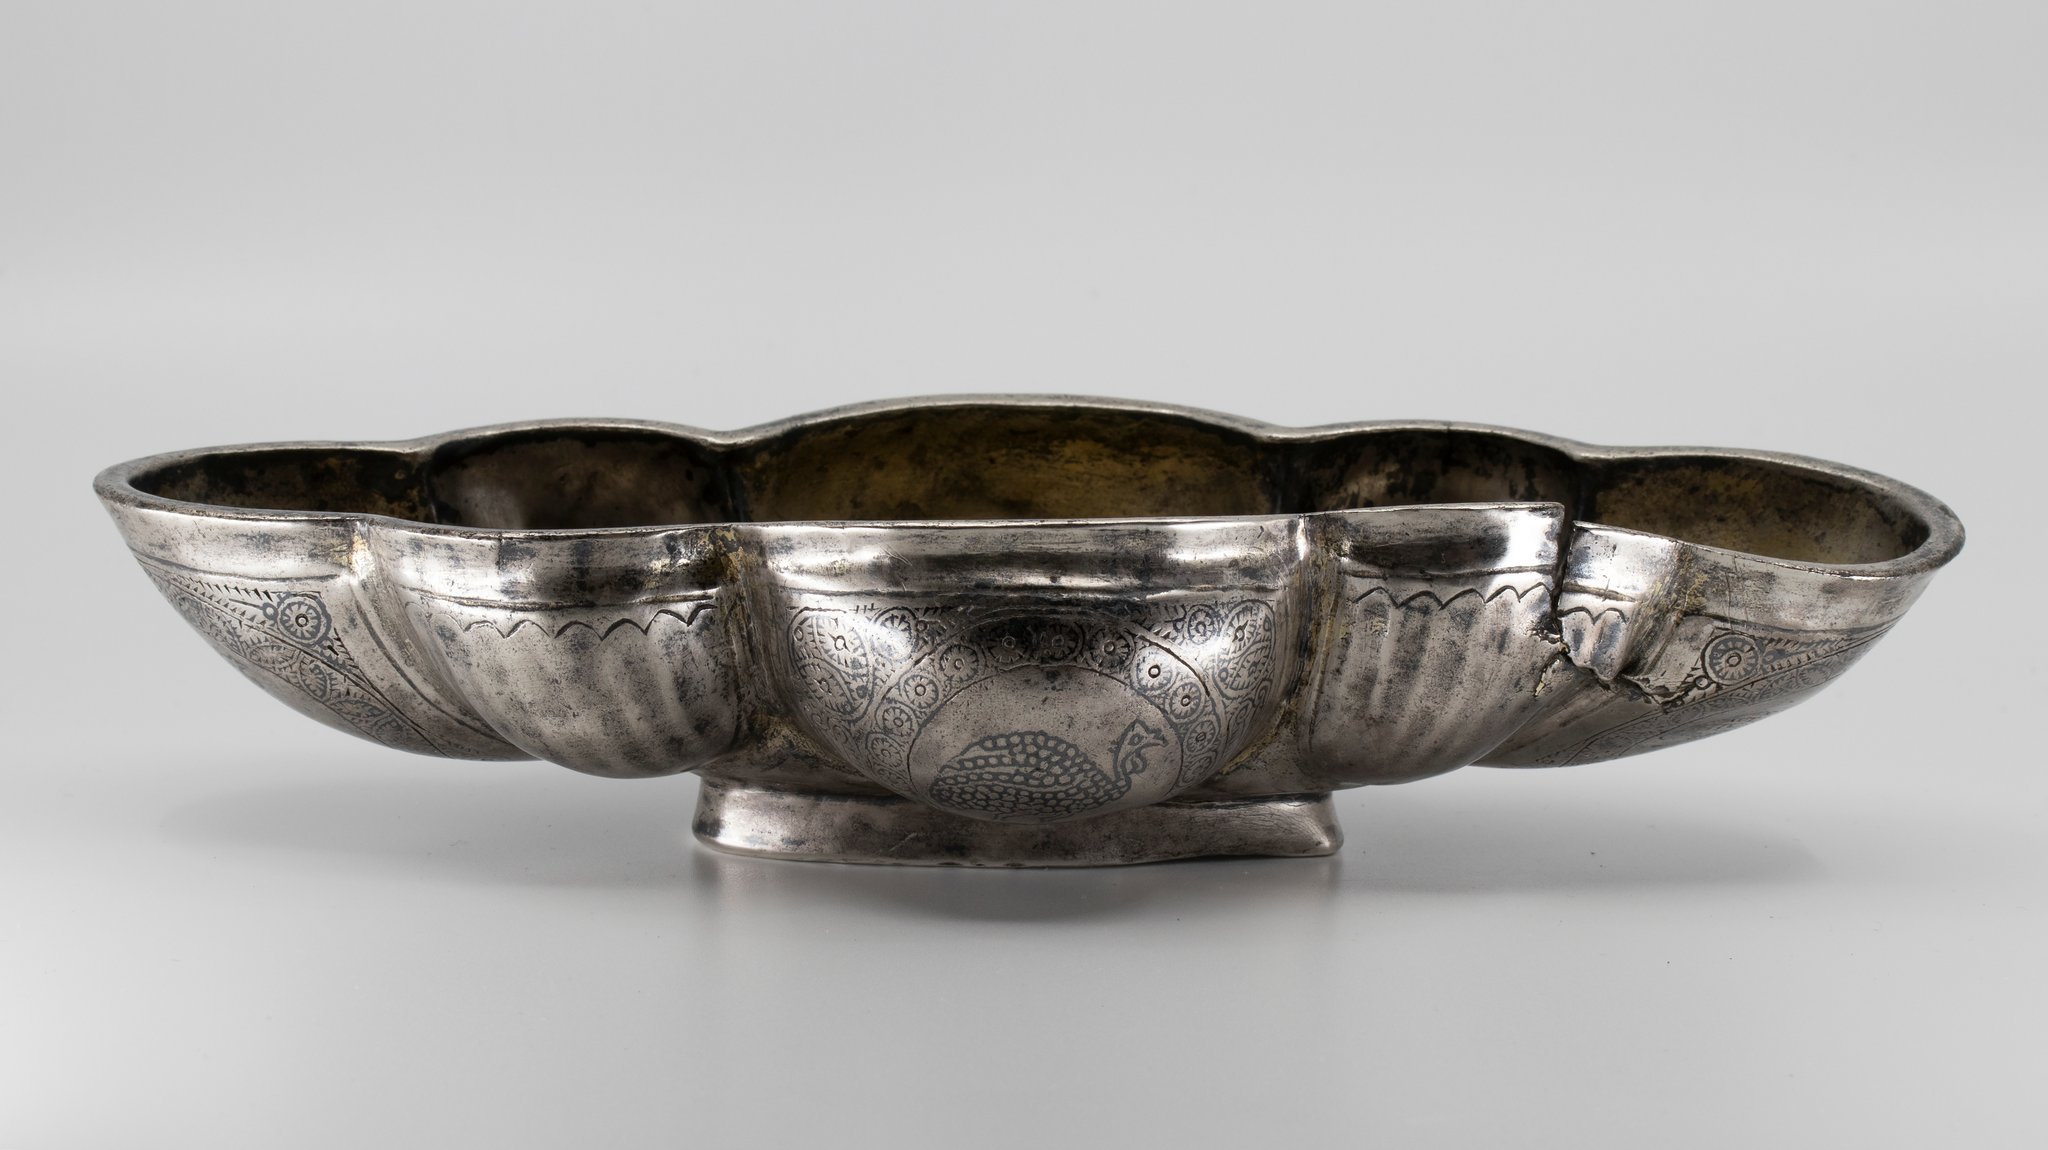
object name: bowl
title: Lobed bowl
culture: sasanian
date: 501-700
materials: niello, silver gilt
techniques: inlay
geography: central asia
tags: birds